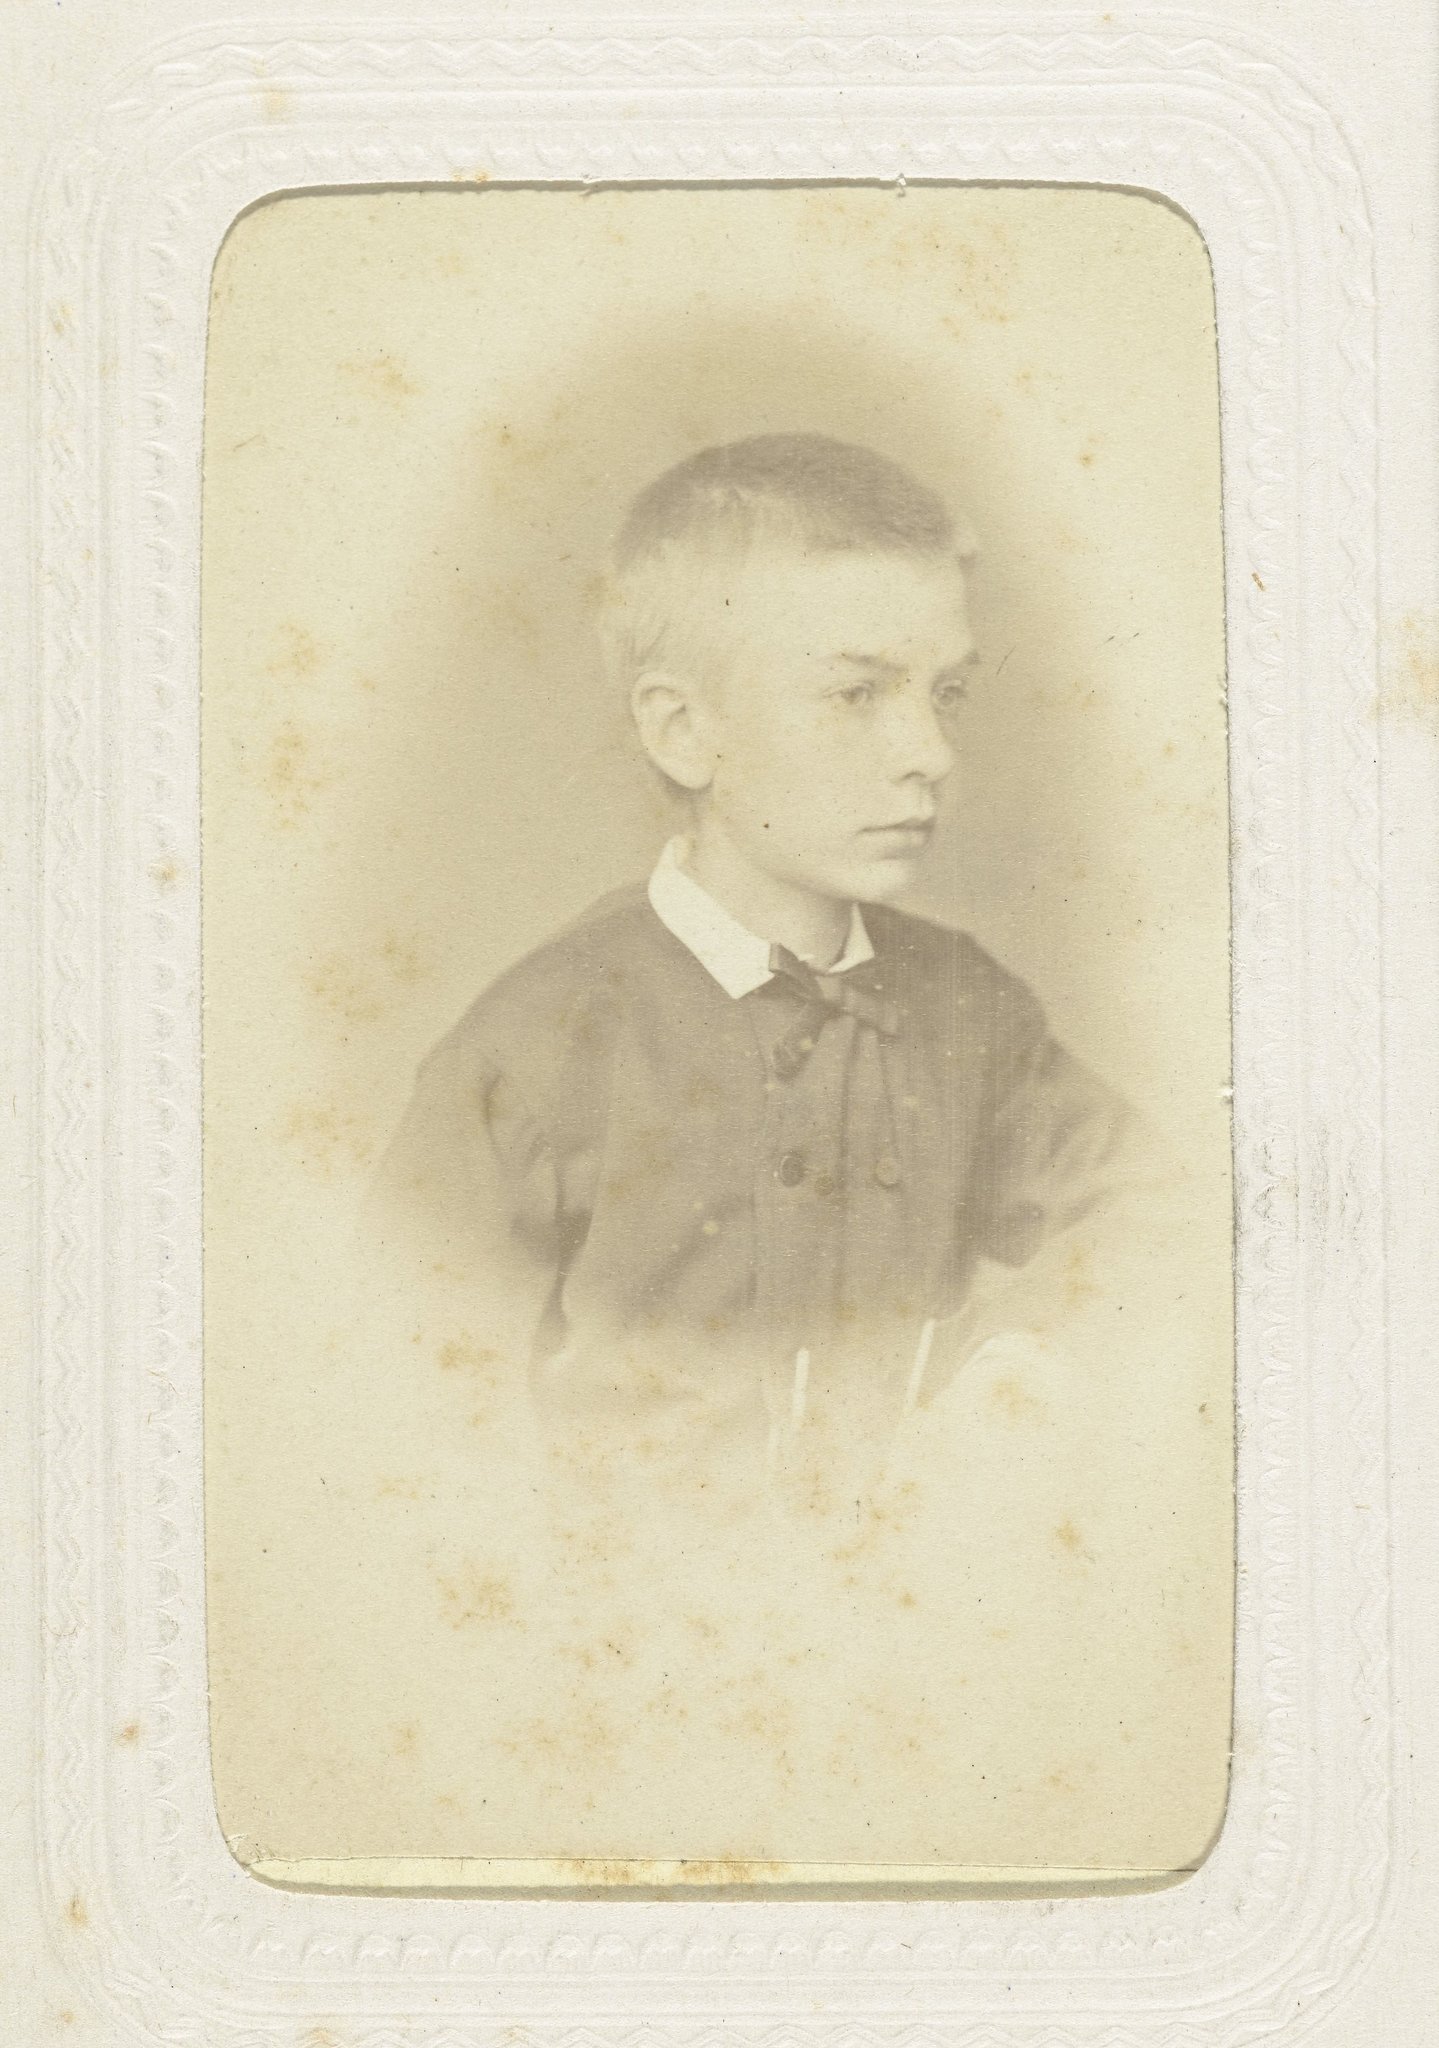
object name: carte de visite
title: Studioportret van een jongen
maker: albert greiner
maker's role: fotograaf, fotostudio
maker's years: 1833-1890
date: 1863-1866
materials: cardboard, paper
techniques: albumen print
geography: amsterdam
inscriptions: name: ‘Albert Greiner Amsterdam’